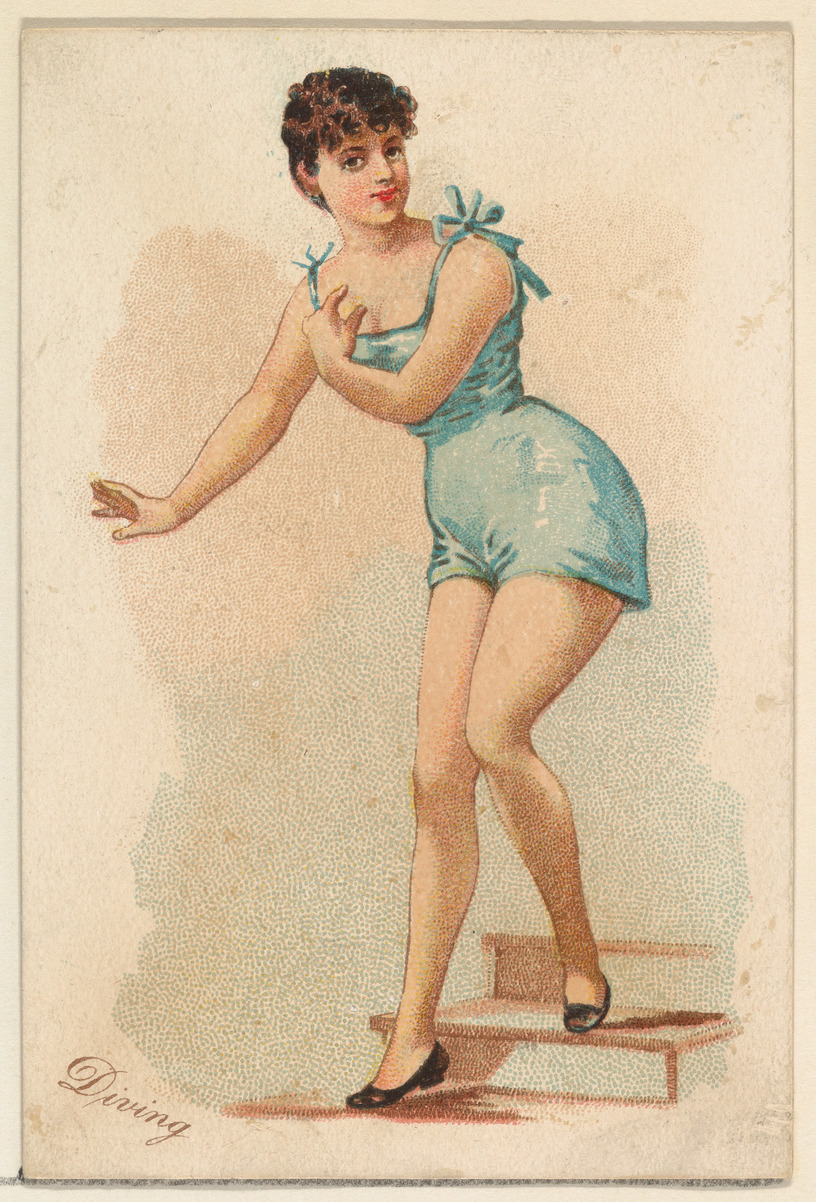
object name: print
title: Diving, from the Pretty Athletes series (N196) issued by Wm. S. Kimball & Co.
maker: william s. kimball & company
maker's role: publisher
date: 1889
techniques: color lithograph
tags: women,athletes